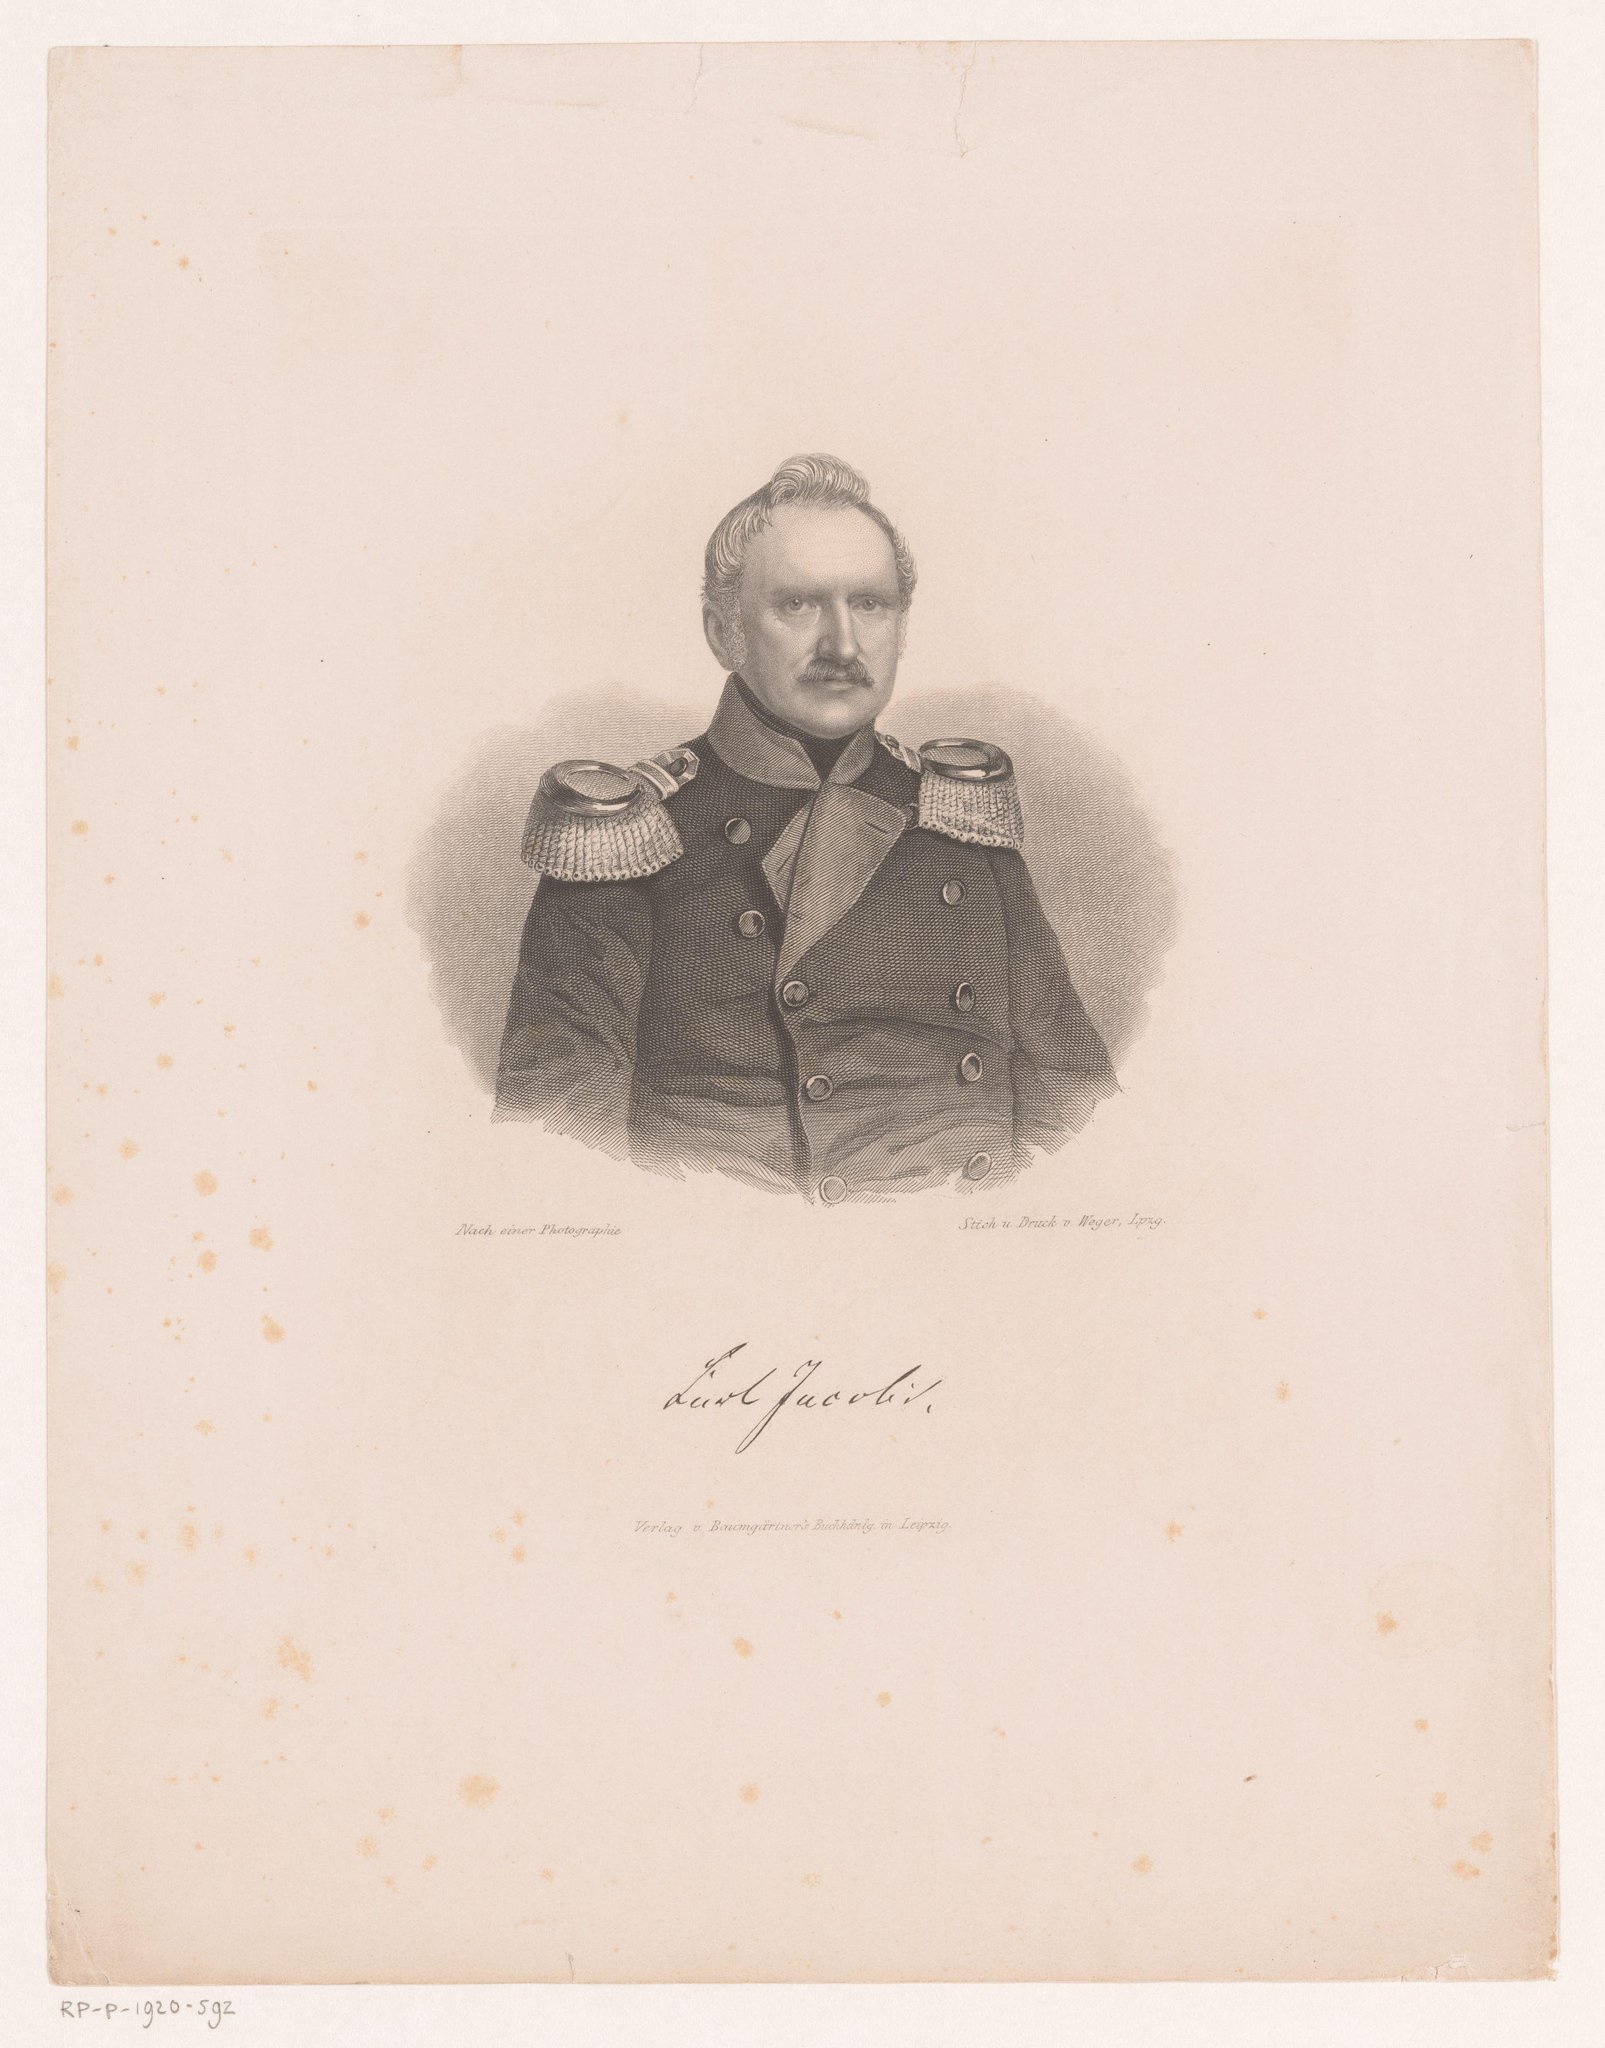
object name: print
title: Portret van Karl von Jacobi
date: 1849-1892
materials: paper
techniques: engraving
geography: leipzig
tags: historical persons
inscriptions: collector's mark: Lugt 2228